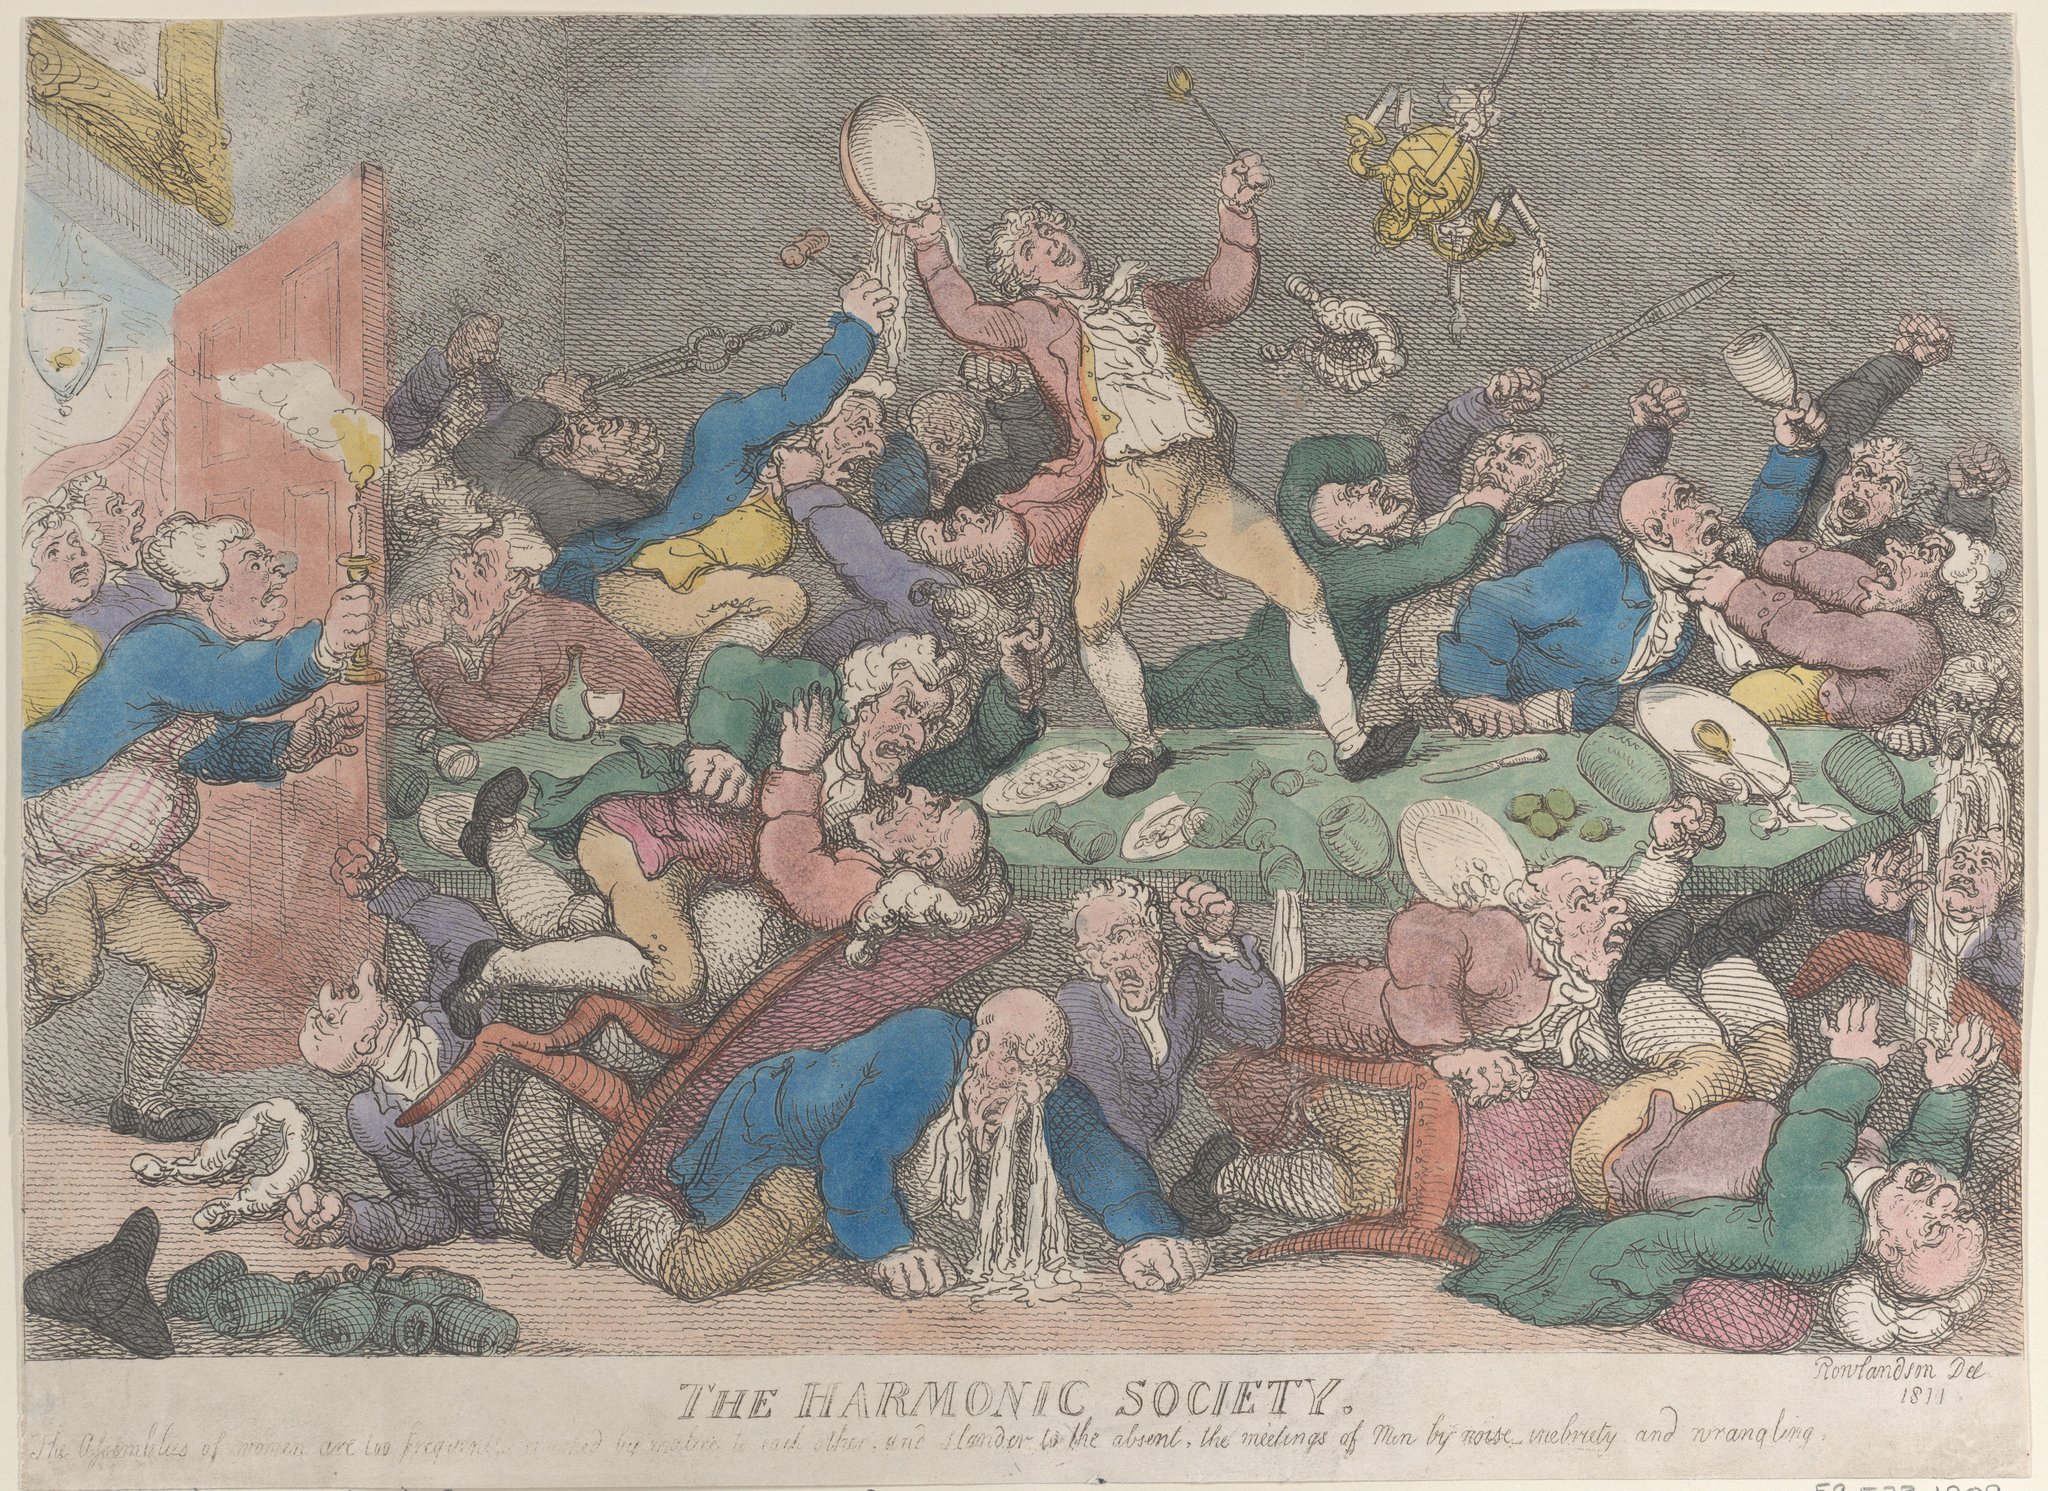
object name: print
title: The Harmonic Society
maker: thomas rowlandson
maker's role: artist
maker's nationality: british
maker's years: 1757-1827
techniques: etching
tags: satire,drunkenness,men,dining